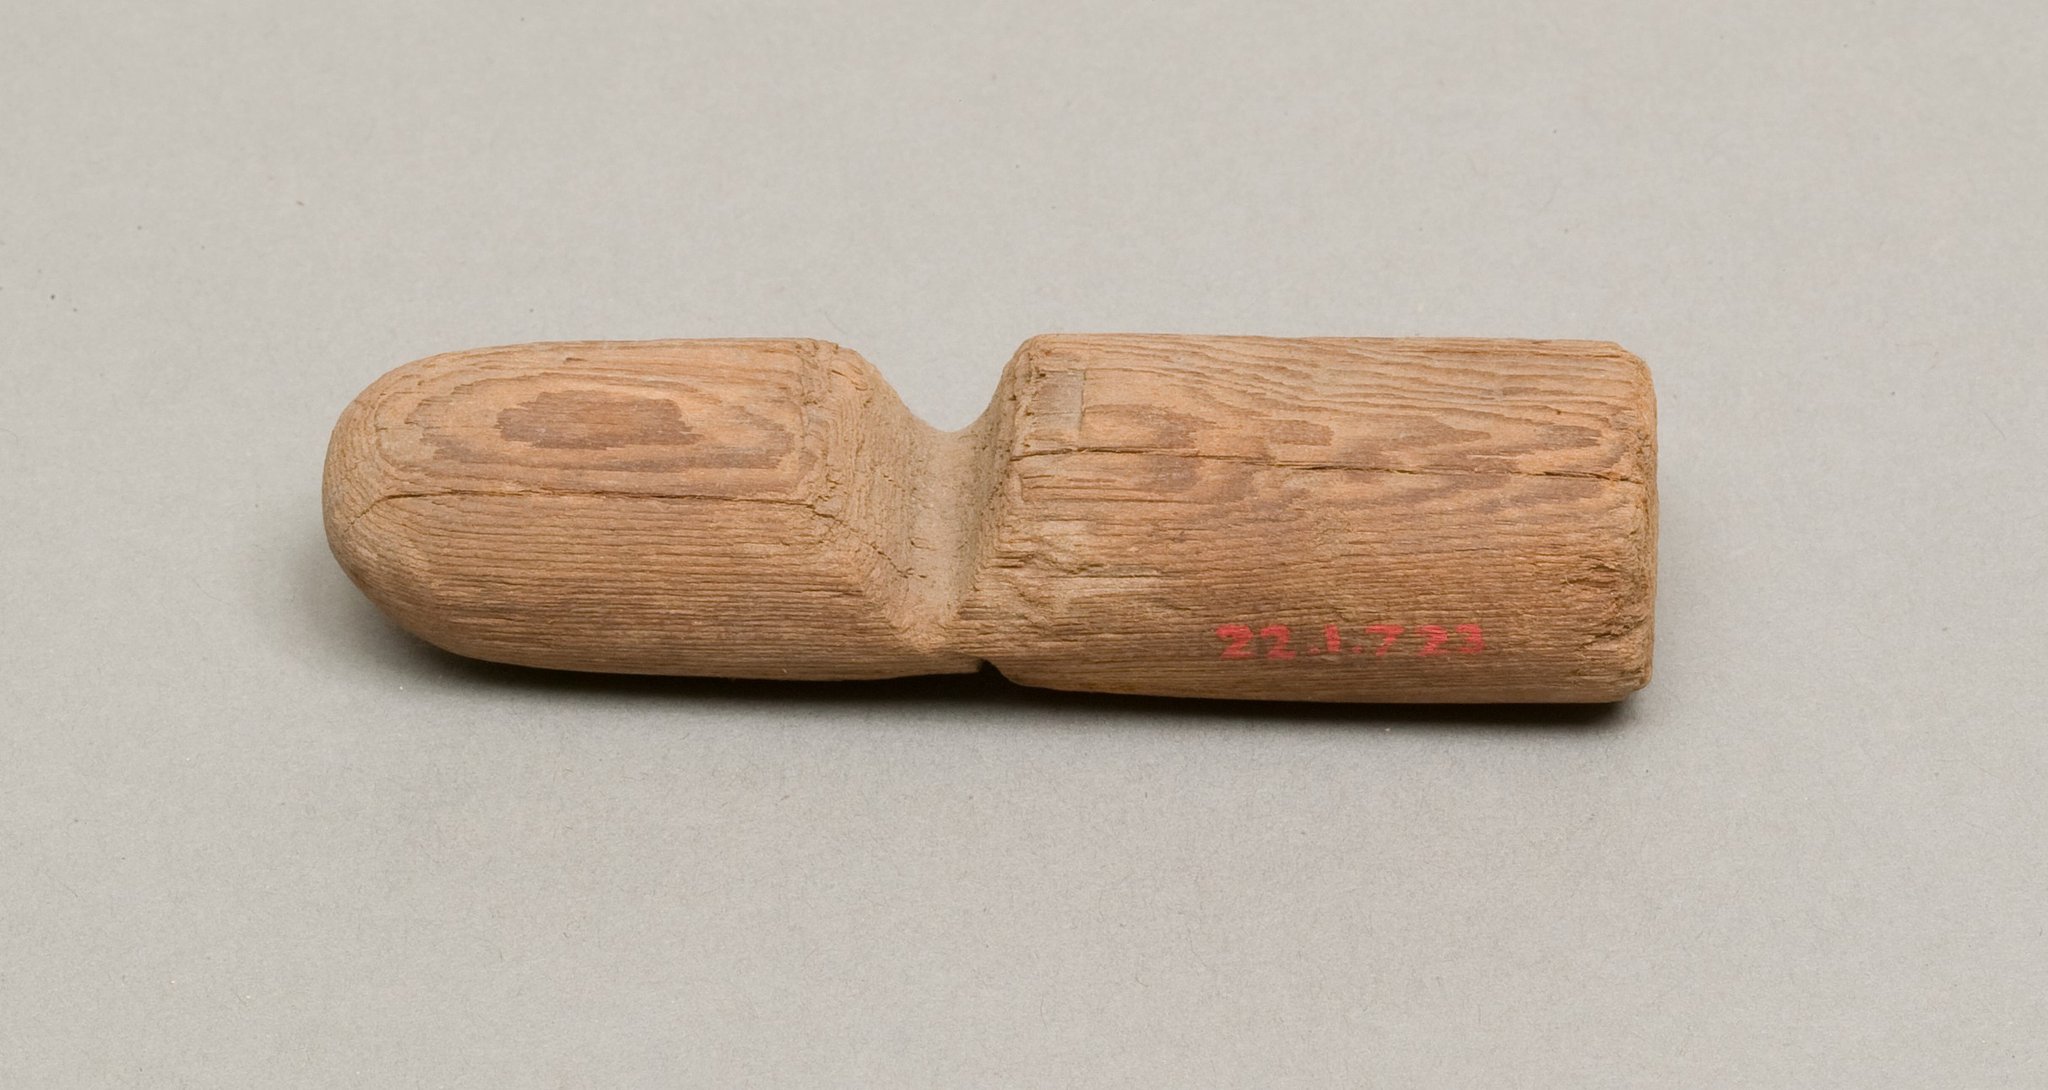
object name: heddle jack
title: Loom Heddle Jack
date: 1850-1070 BCE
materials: wood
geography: egypt